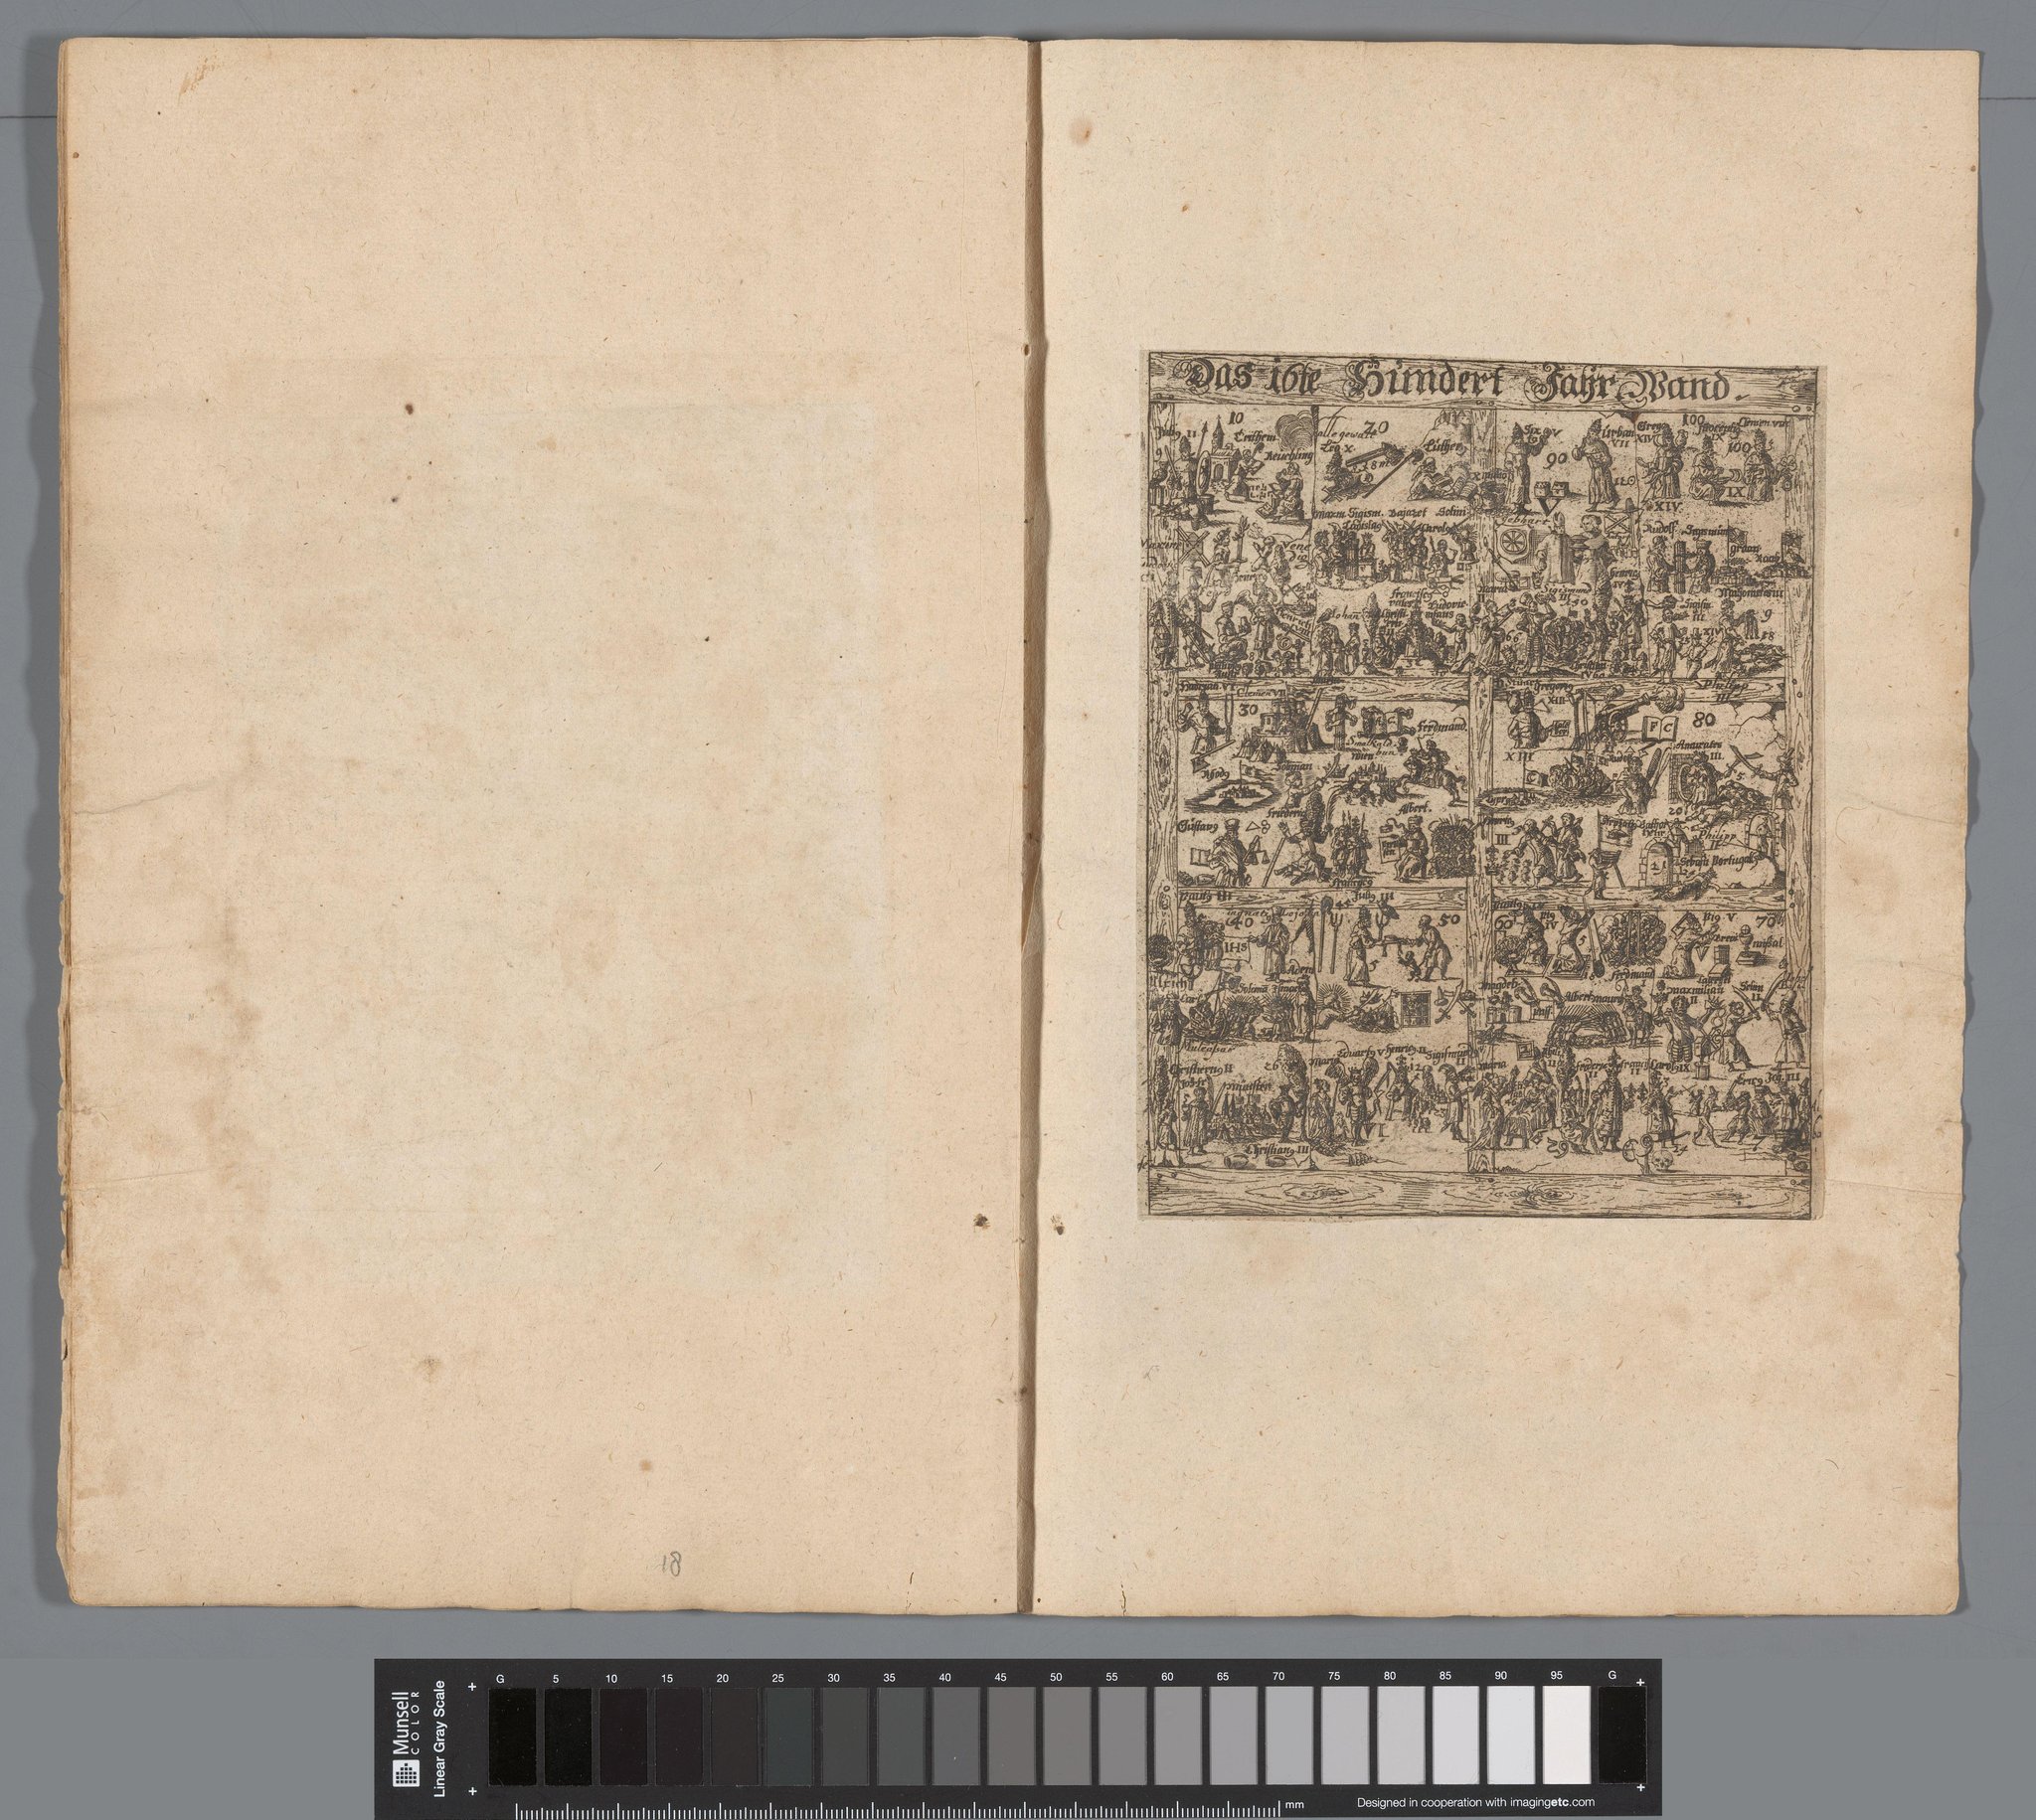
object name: print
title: Veertiende eeuw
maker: Anonymous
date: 1667-1672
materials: paper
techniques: engraving, etching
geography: germany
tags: container of glass: bottle, jar, vase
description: Prenten afkomstig uit een editie van: Johannes Buno, Historische Bilder/ Darinnen Idea Historiae Universalis : Eine kurtze Summarische Abbildung Der fürnehmsten Geist- und Weltlichen Geschichte durch die vier Monarchien ..., eerst uitgegeven door Bartold Elers in Lüneburg in 1672.